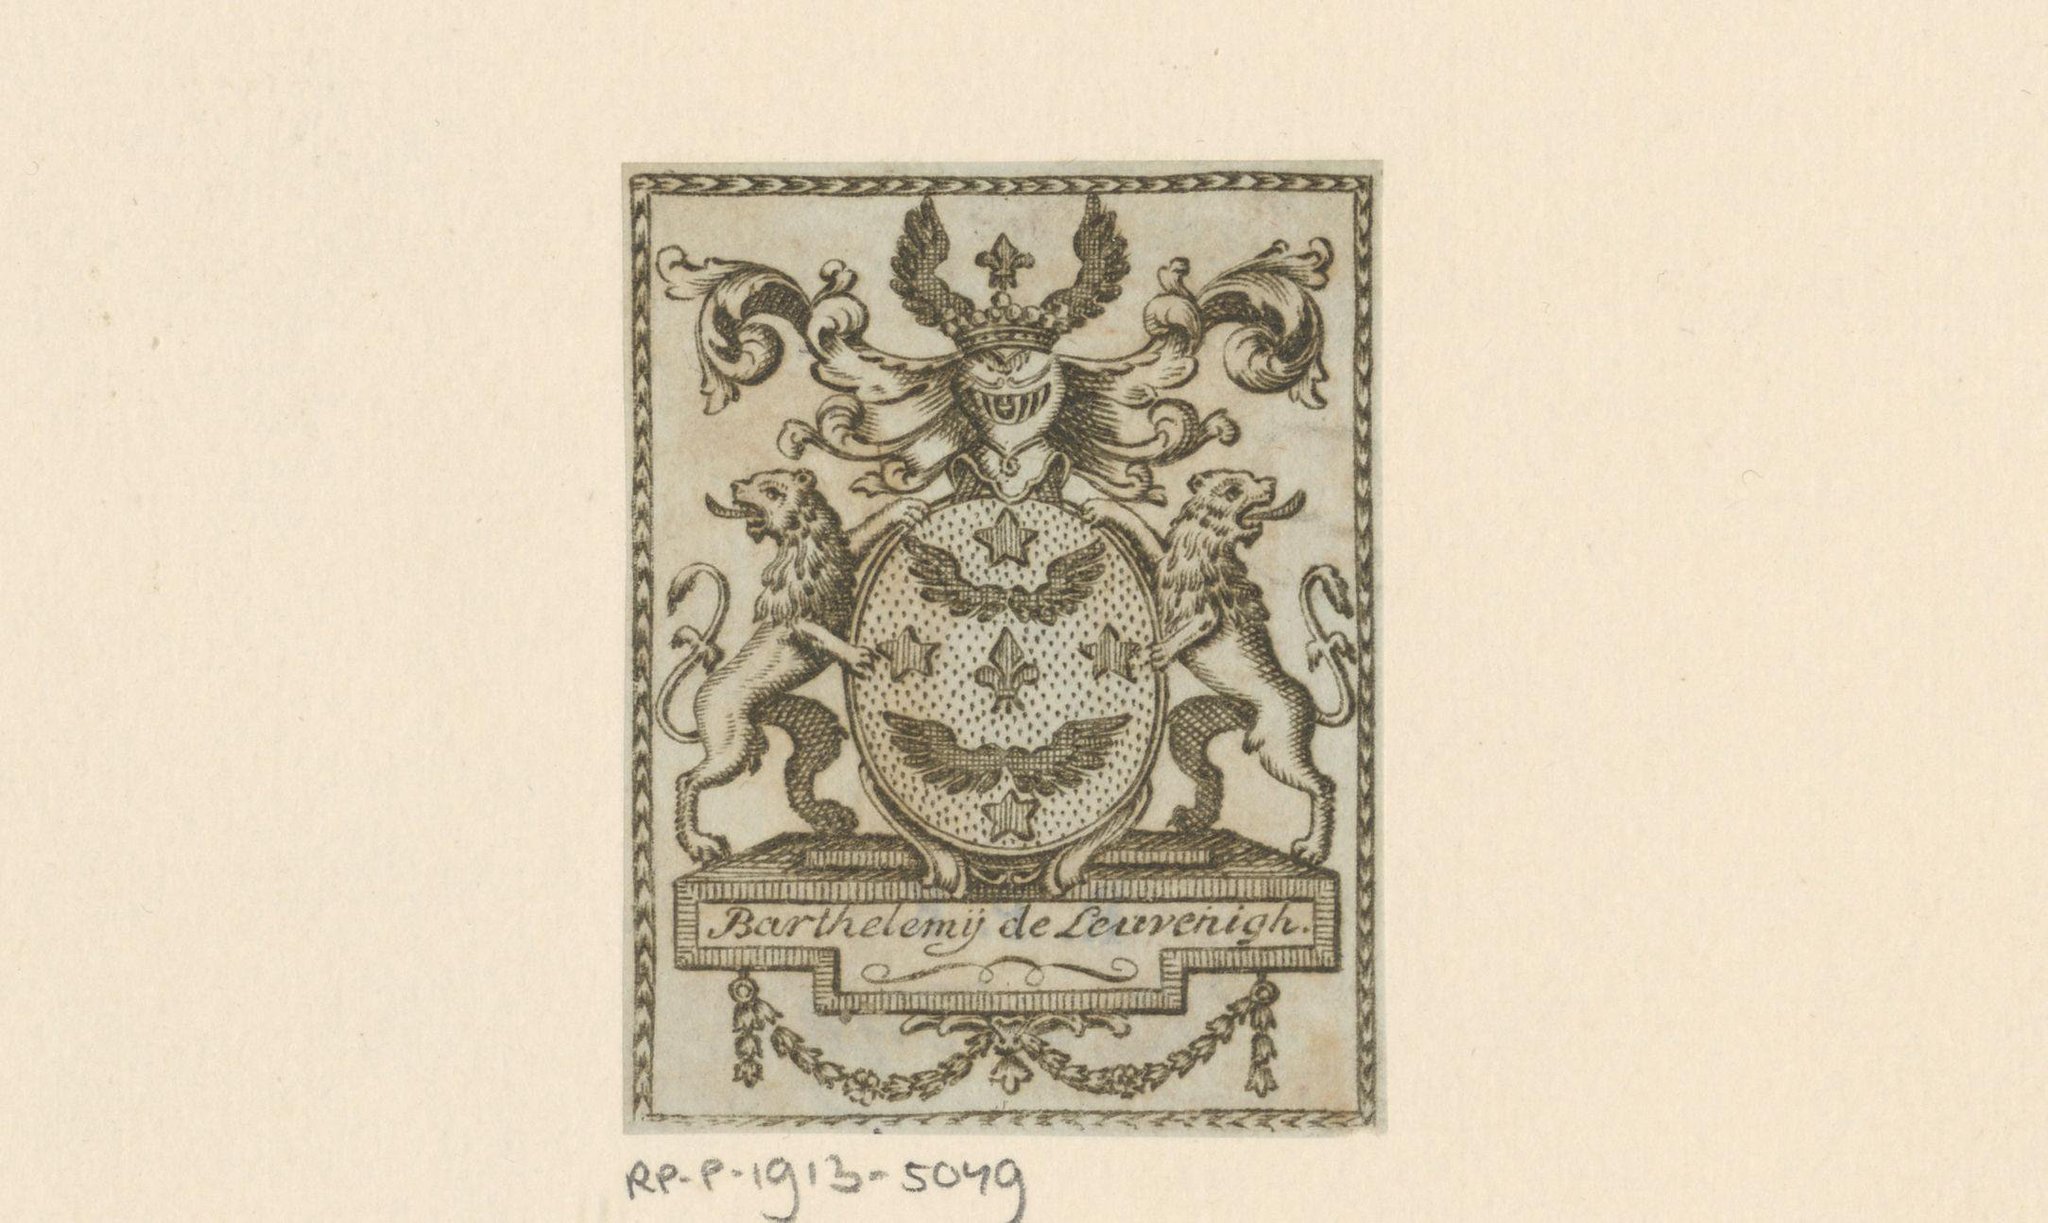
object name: bookplate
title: Ex libris van Berthelemij de Leuvenigh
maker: Anonymous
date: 1700-1799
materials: paper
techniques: etching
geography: netherlands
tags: beasts of prey, predatory animals: lion, armorial bearing, heraldry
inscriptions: collector's mark: Lugt 2233, collector's mark: Lugt 2760